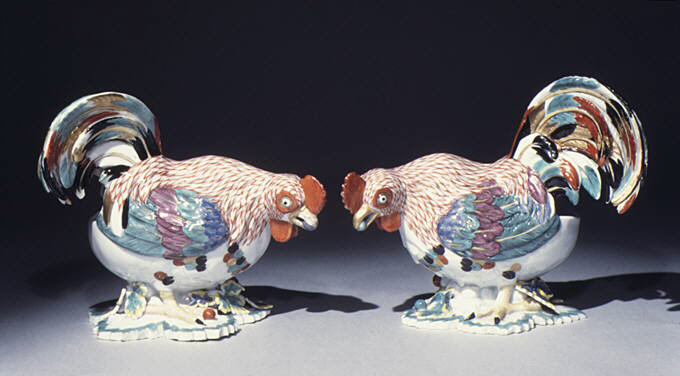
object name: figure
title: Chinese rooster (one of a pair)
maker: meissen manufactory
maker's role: manufactory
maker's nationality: german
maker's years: 1710-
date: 1732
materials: hard paste porcelain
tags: roosters